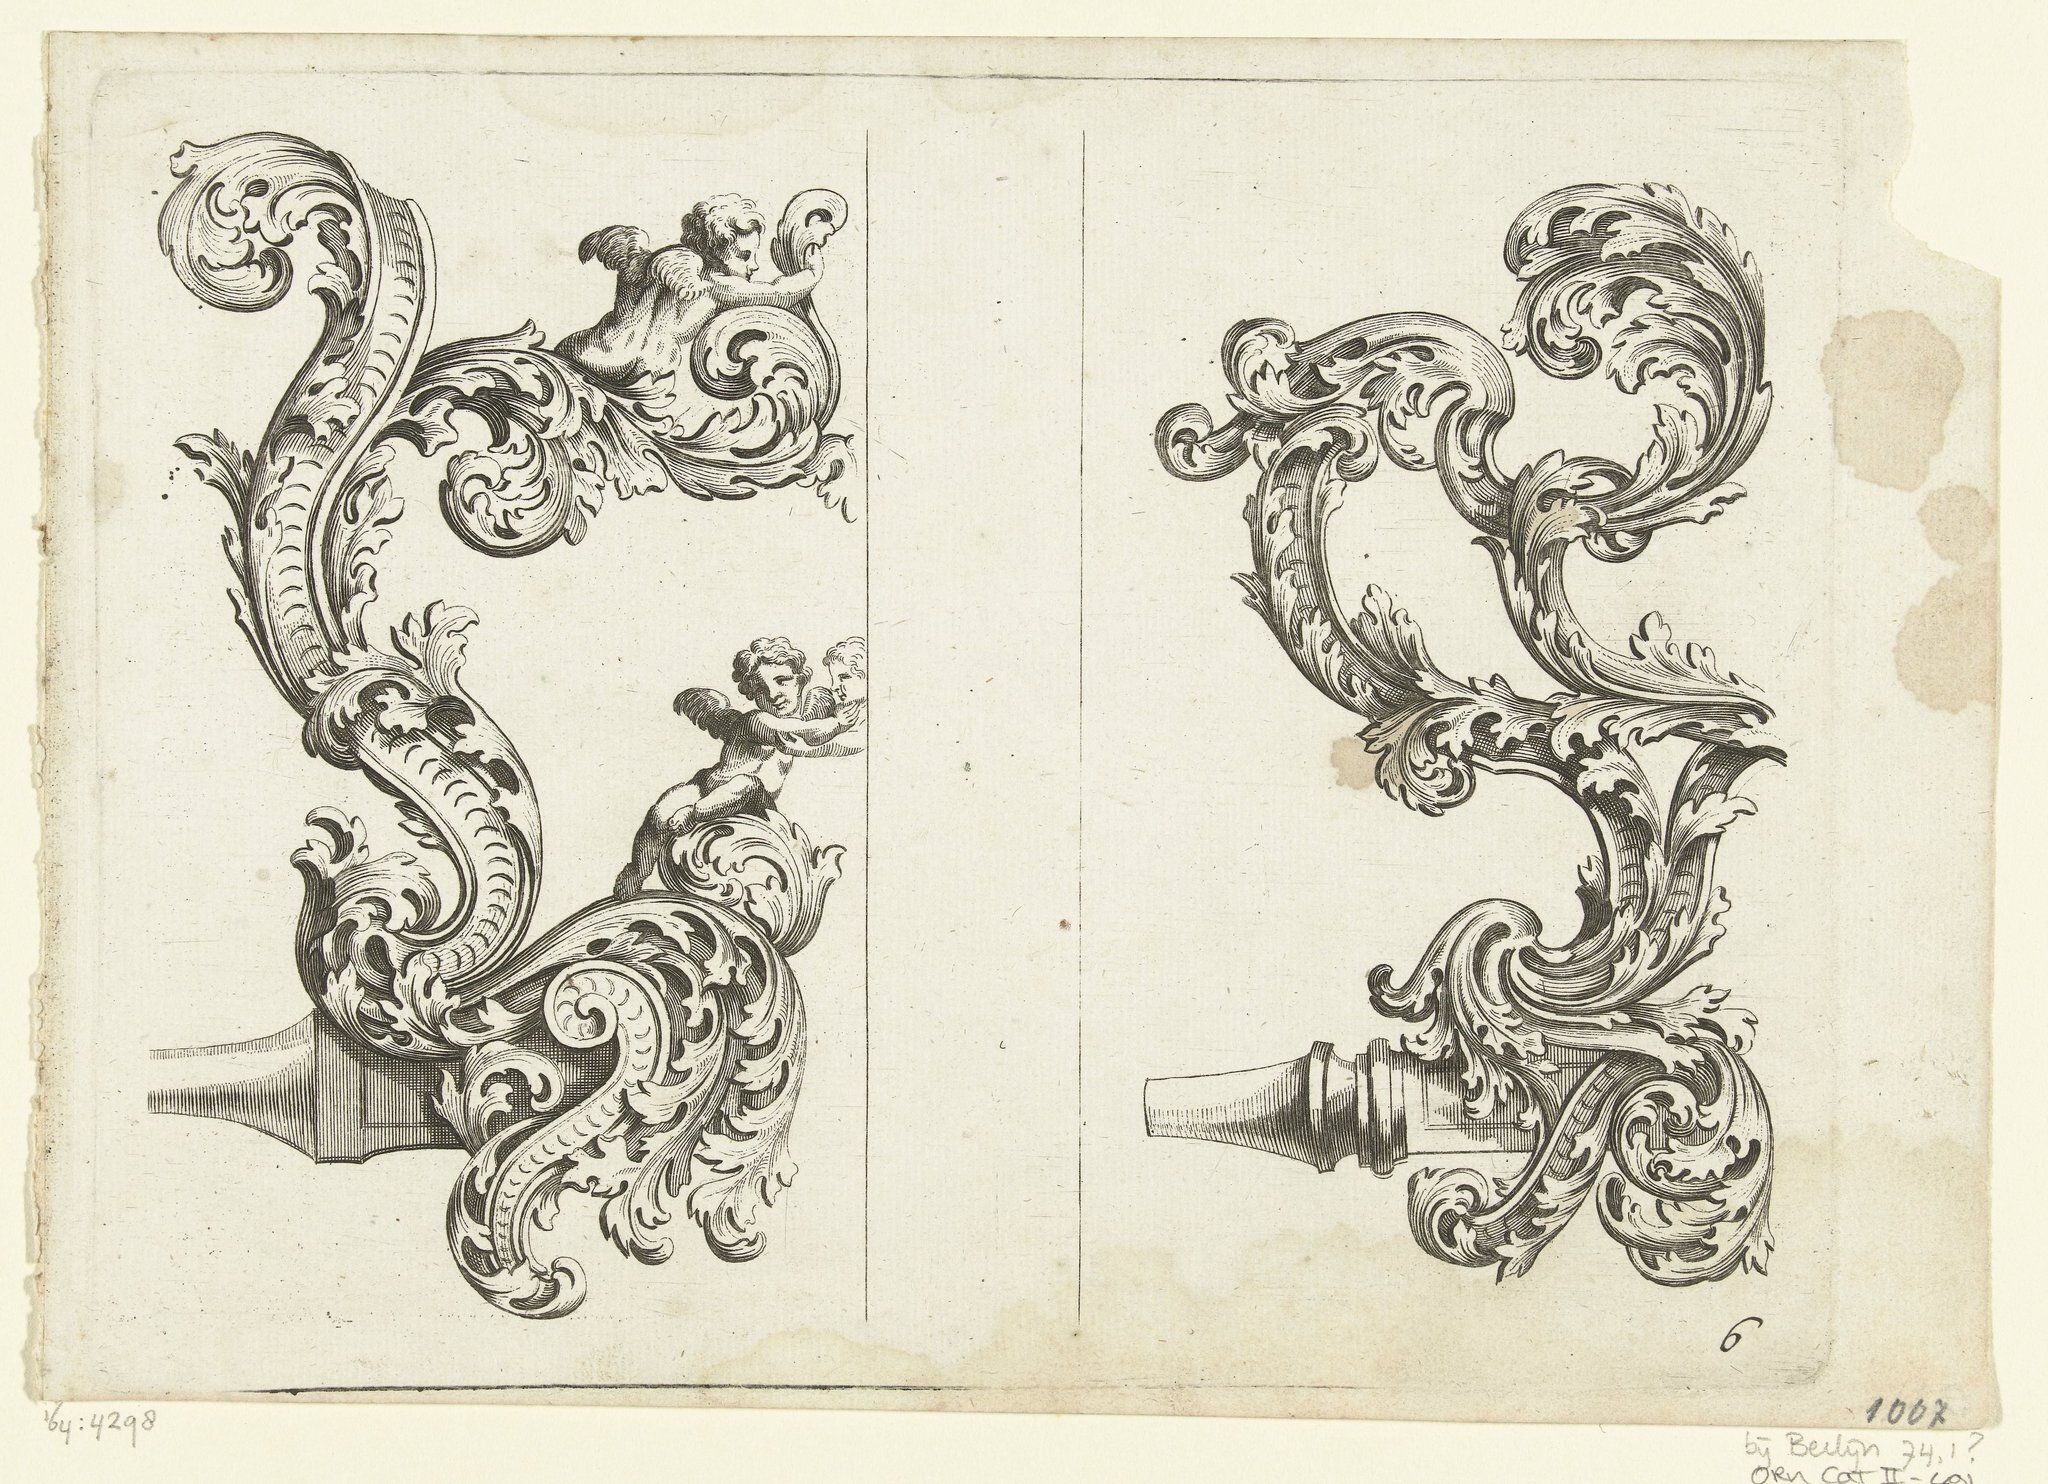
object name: ornament print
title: Twee achterframes voor rijtuig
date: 1668-1708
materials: paper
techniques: etching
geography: nuremberg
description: Zowel links als rechts is de linkerhelft van een achterframe van een rijtuig afgebeeld.